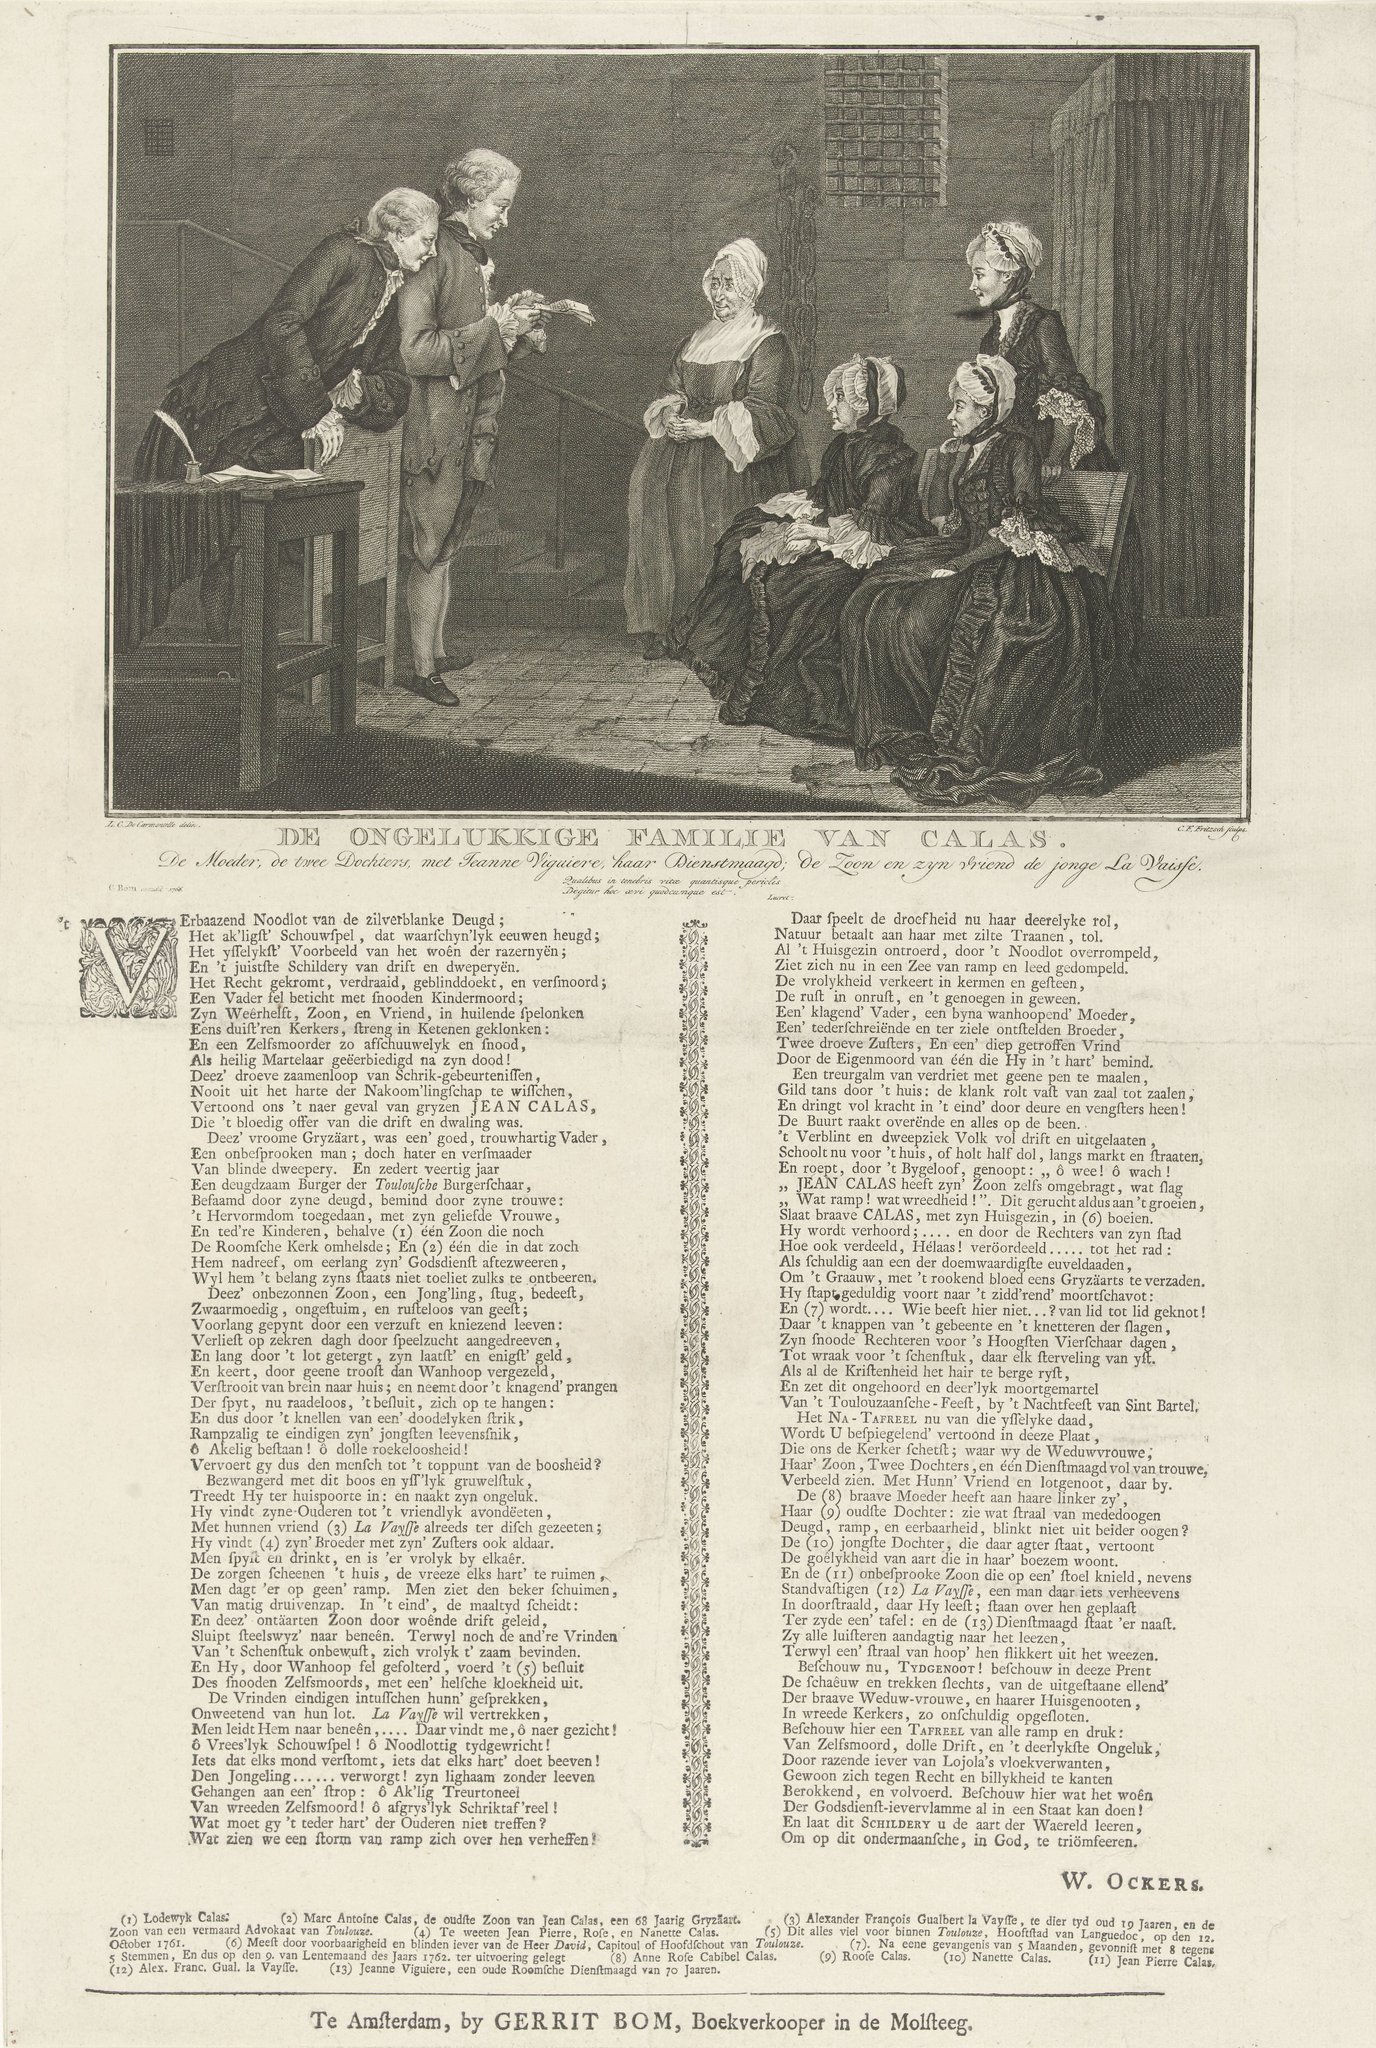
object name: print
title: Familie van Calas in de gevangenis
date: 1766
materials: paper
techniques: etching, letterpress printing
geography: amsterdam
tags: historical persons, prisoner in cell or locked place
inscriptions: collector's mark: Lugt 2228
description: De Franse koopman Jean Calas uit Toulouse werd in 1761 valselijk beschuldigd van moord op zijn 30-jarige zoon. Calas (calvinist) zou zijn zoon hebben omgebracht omdat deze zich tot het katholicisme wilde bekeren. Zijn familie, waarover Voltaire zich ontfermde, zit hier in de gevangenis. Rechts zitten moeder en oudste dochter, hierachter staat de jongste dochter. De tweede zoon steunt links op een stoel en staat naast de heer La Vaysse die een document voorleest waaruit de familie hoop put. Bij de trap luistert de dienstmeid mee. In maart 1762 werd Calas alsnog ter dood gebracht. Op het blad onder de voorstelling staat in twee kolommen een tekst in het Nederlands. Naar aanleiding van deze gebeurtenis schreef Voltaire zijn 'Traité de la tolerance'.